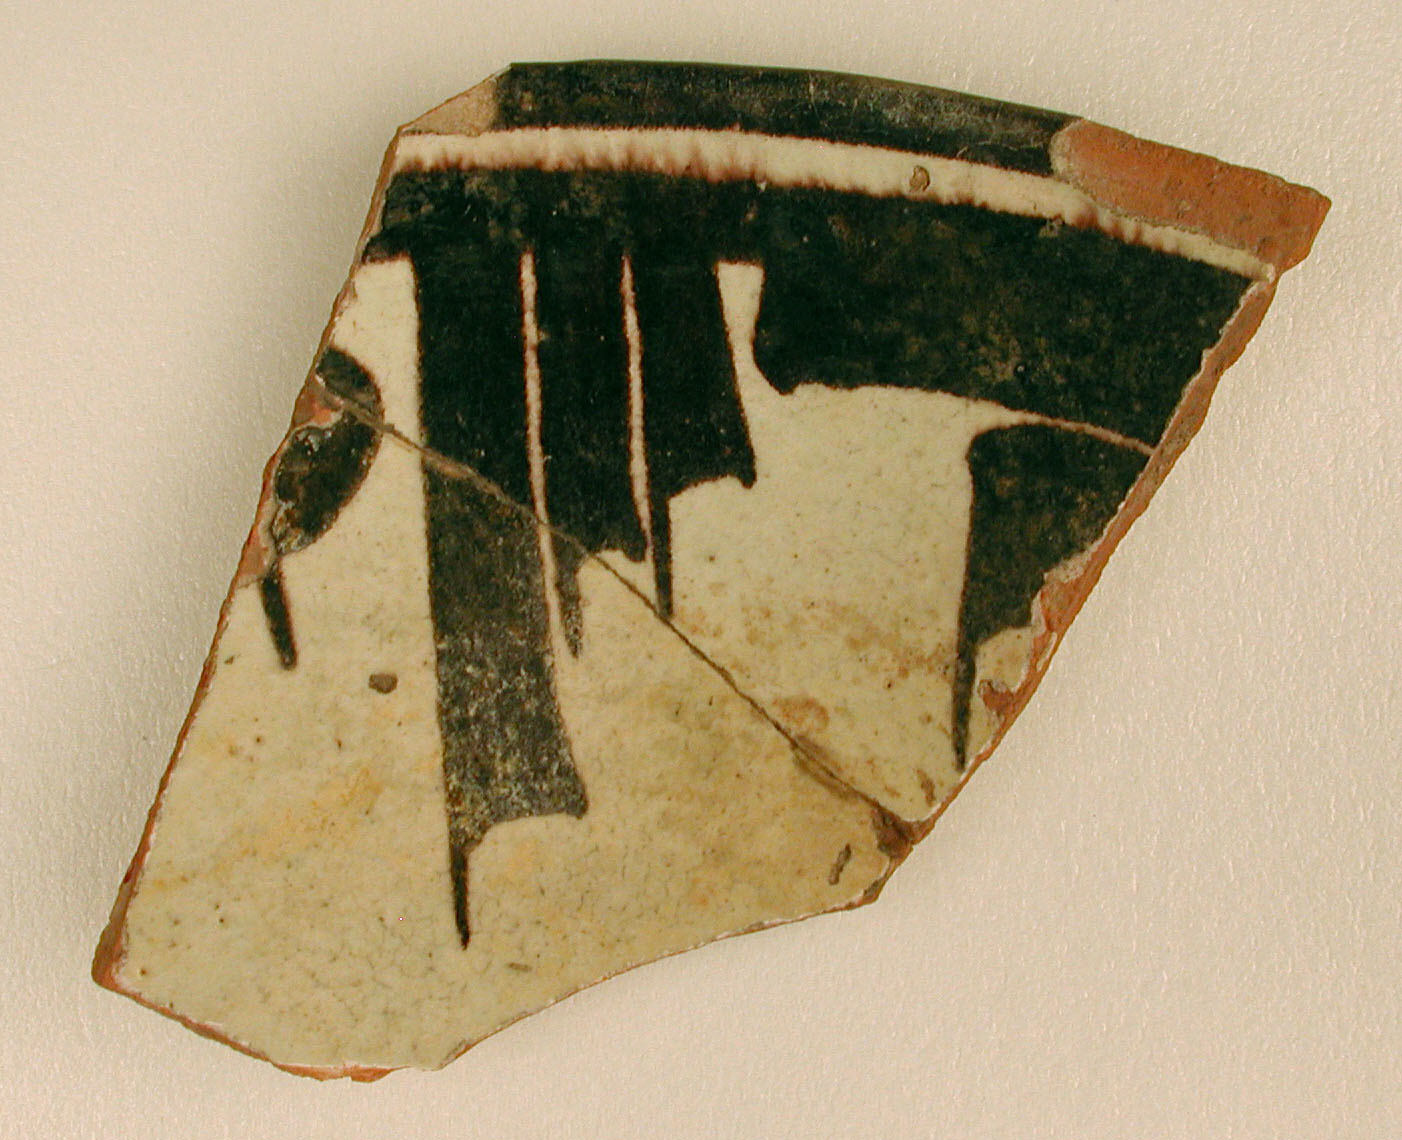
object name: fragment of a bowl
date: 801-1000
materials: earthenware, glaze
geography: iran